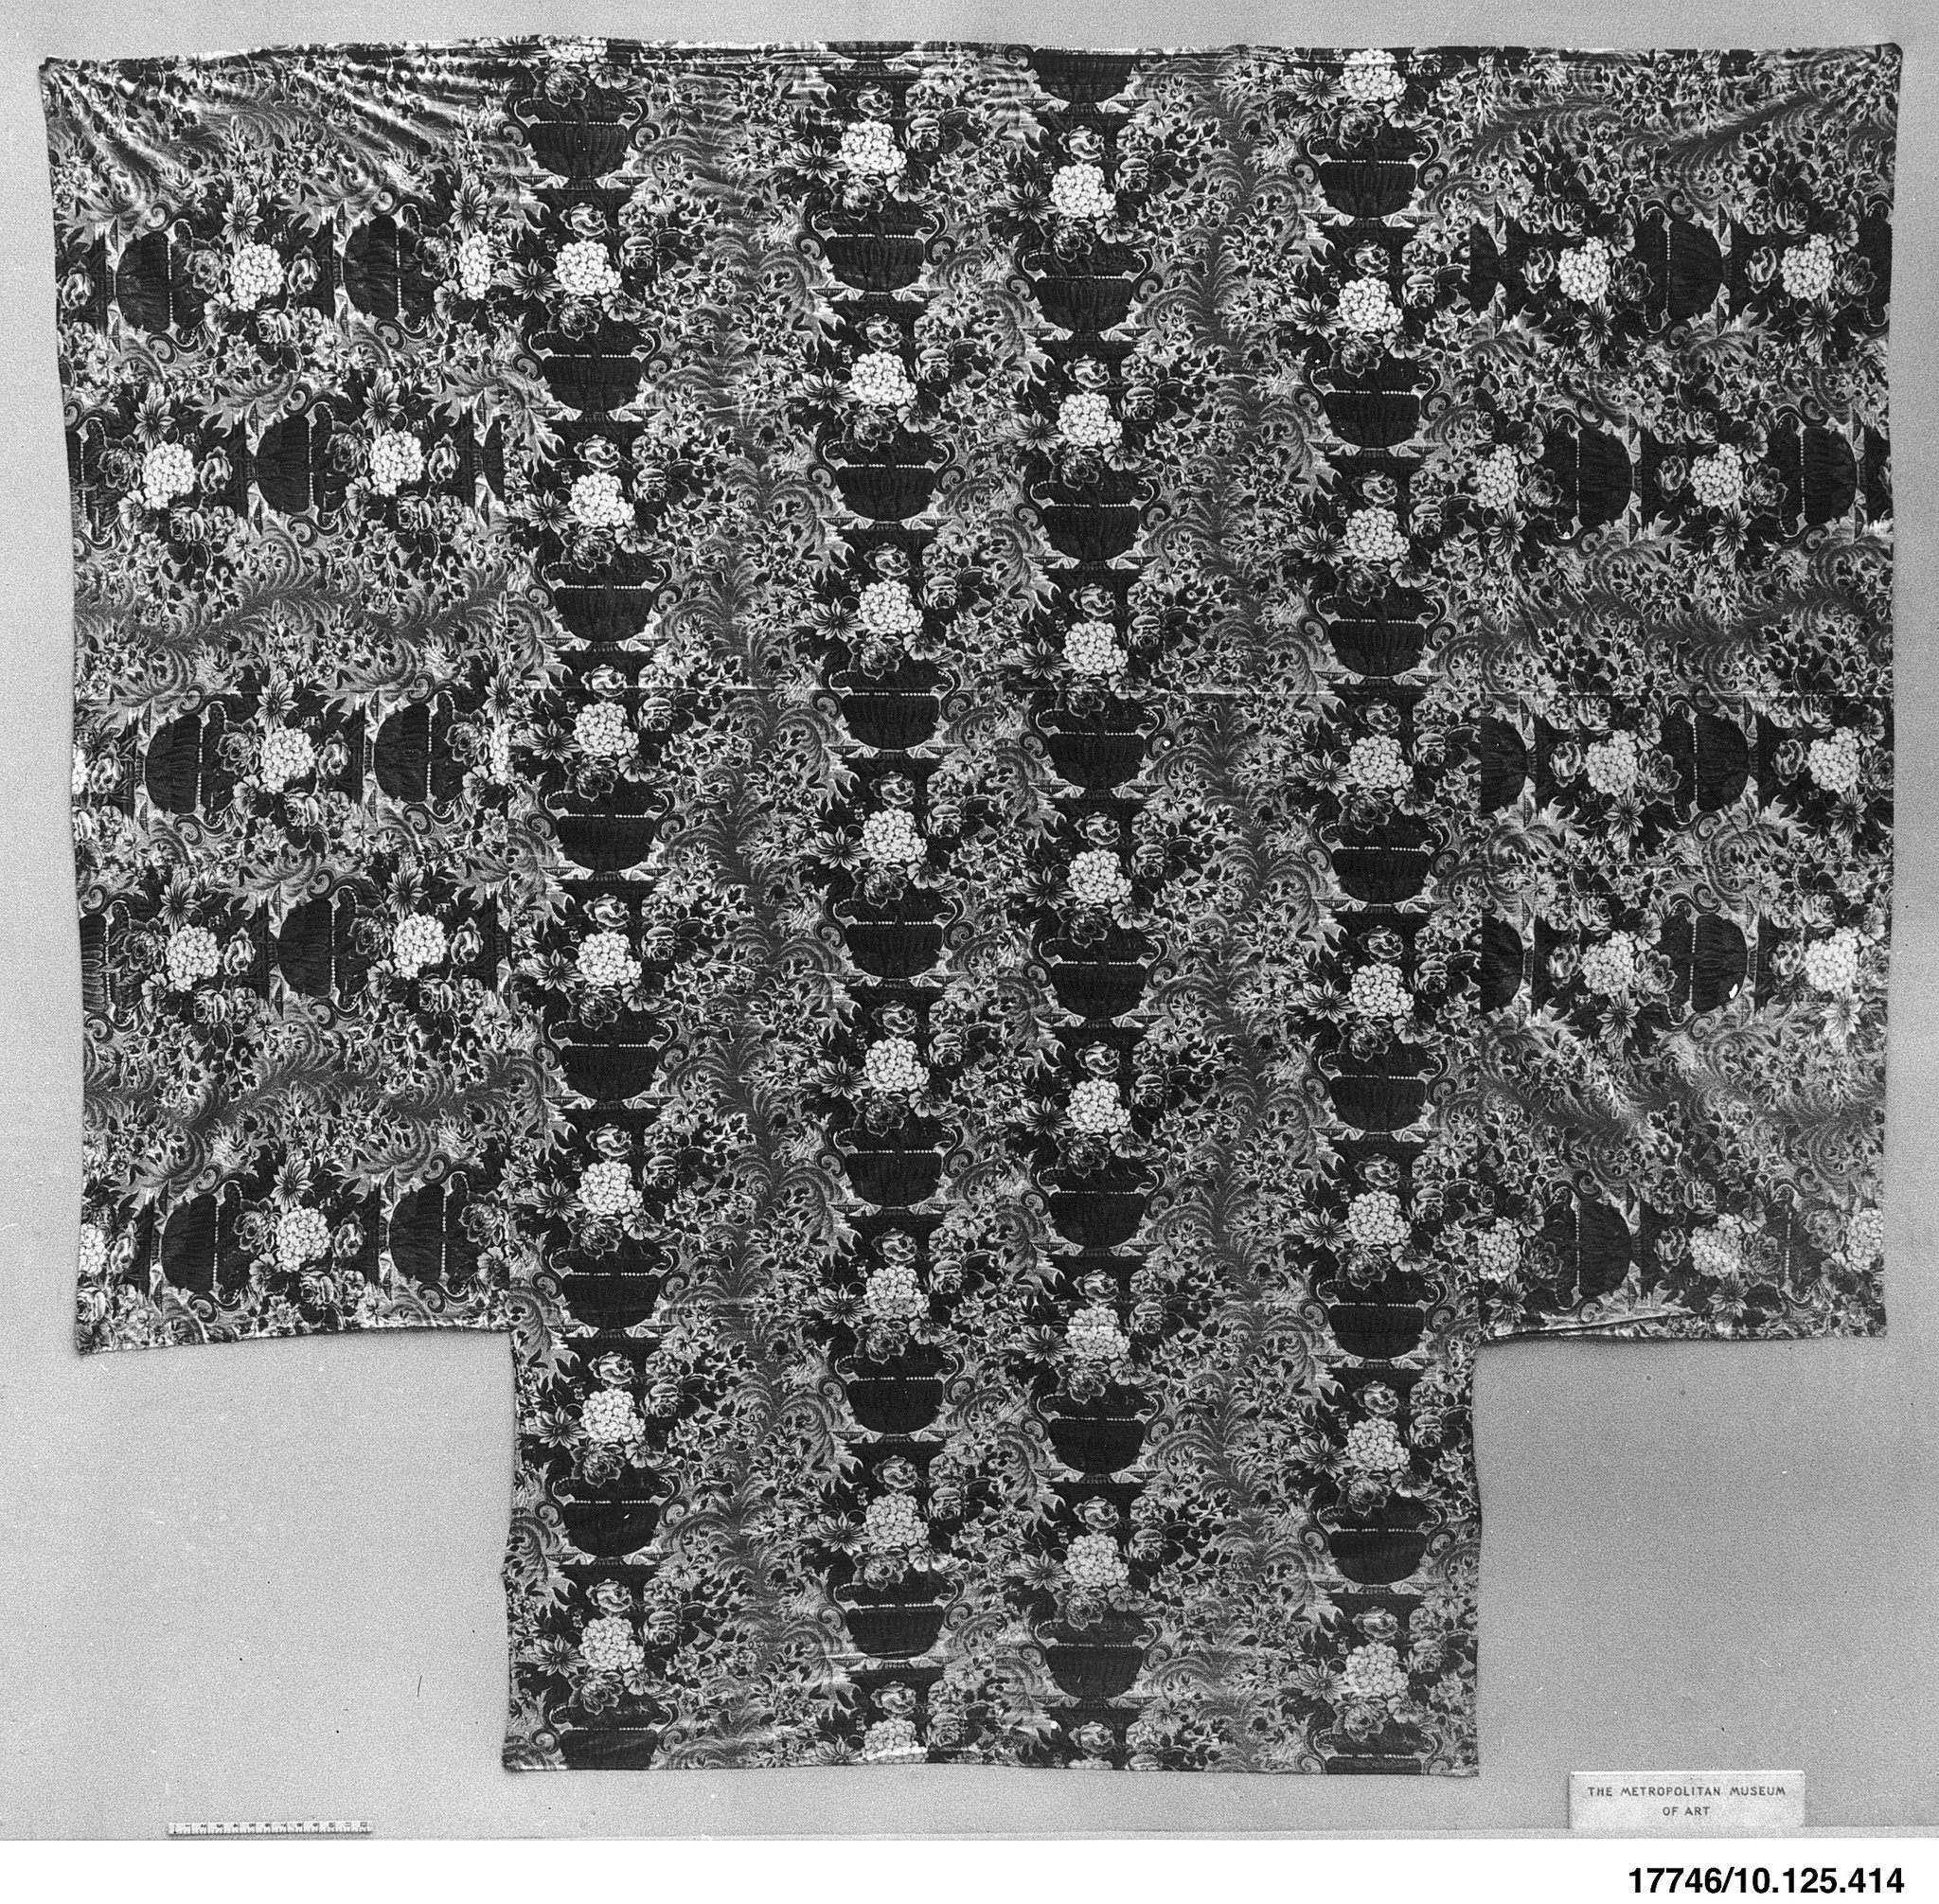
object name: bed cover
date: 1826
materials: cotton